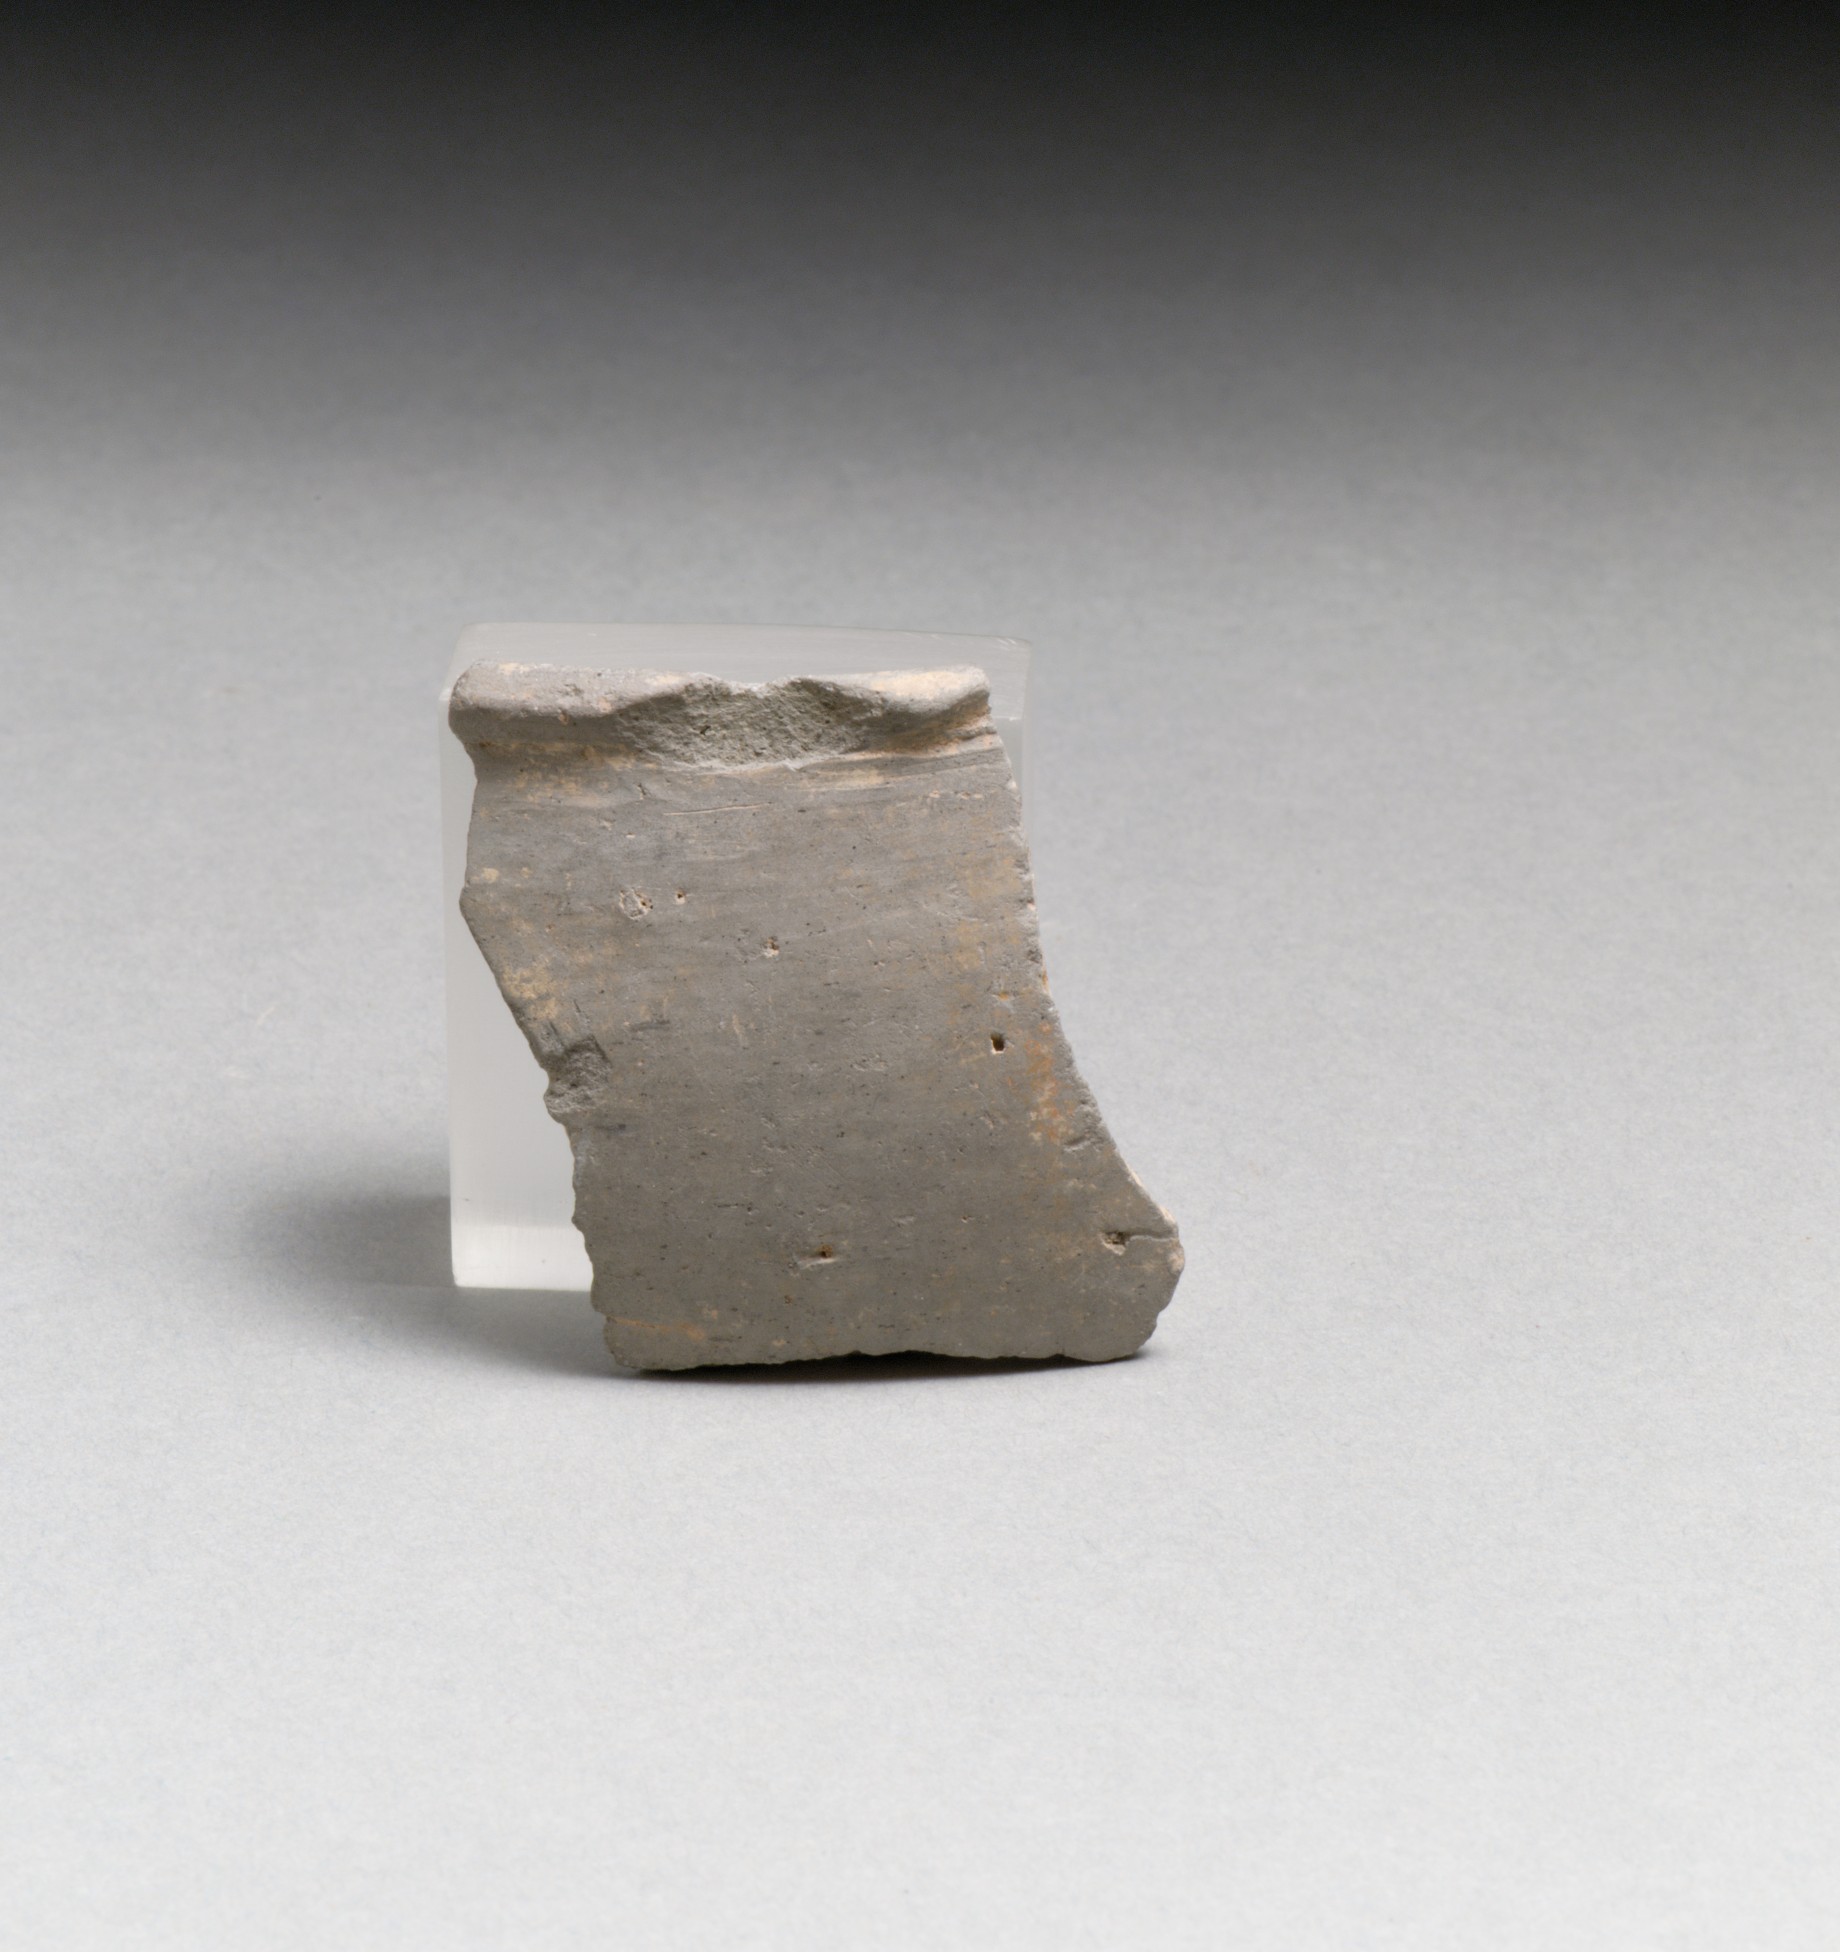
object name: vase fragment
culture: minoan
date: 2600-2000 BCE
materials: terracotta